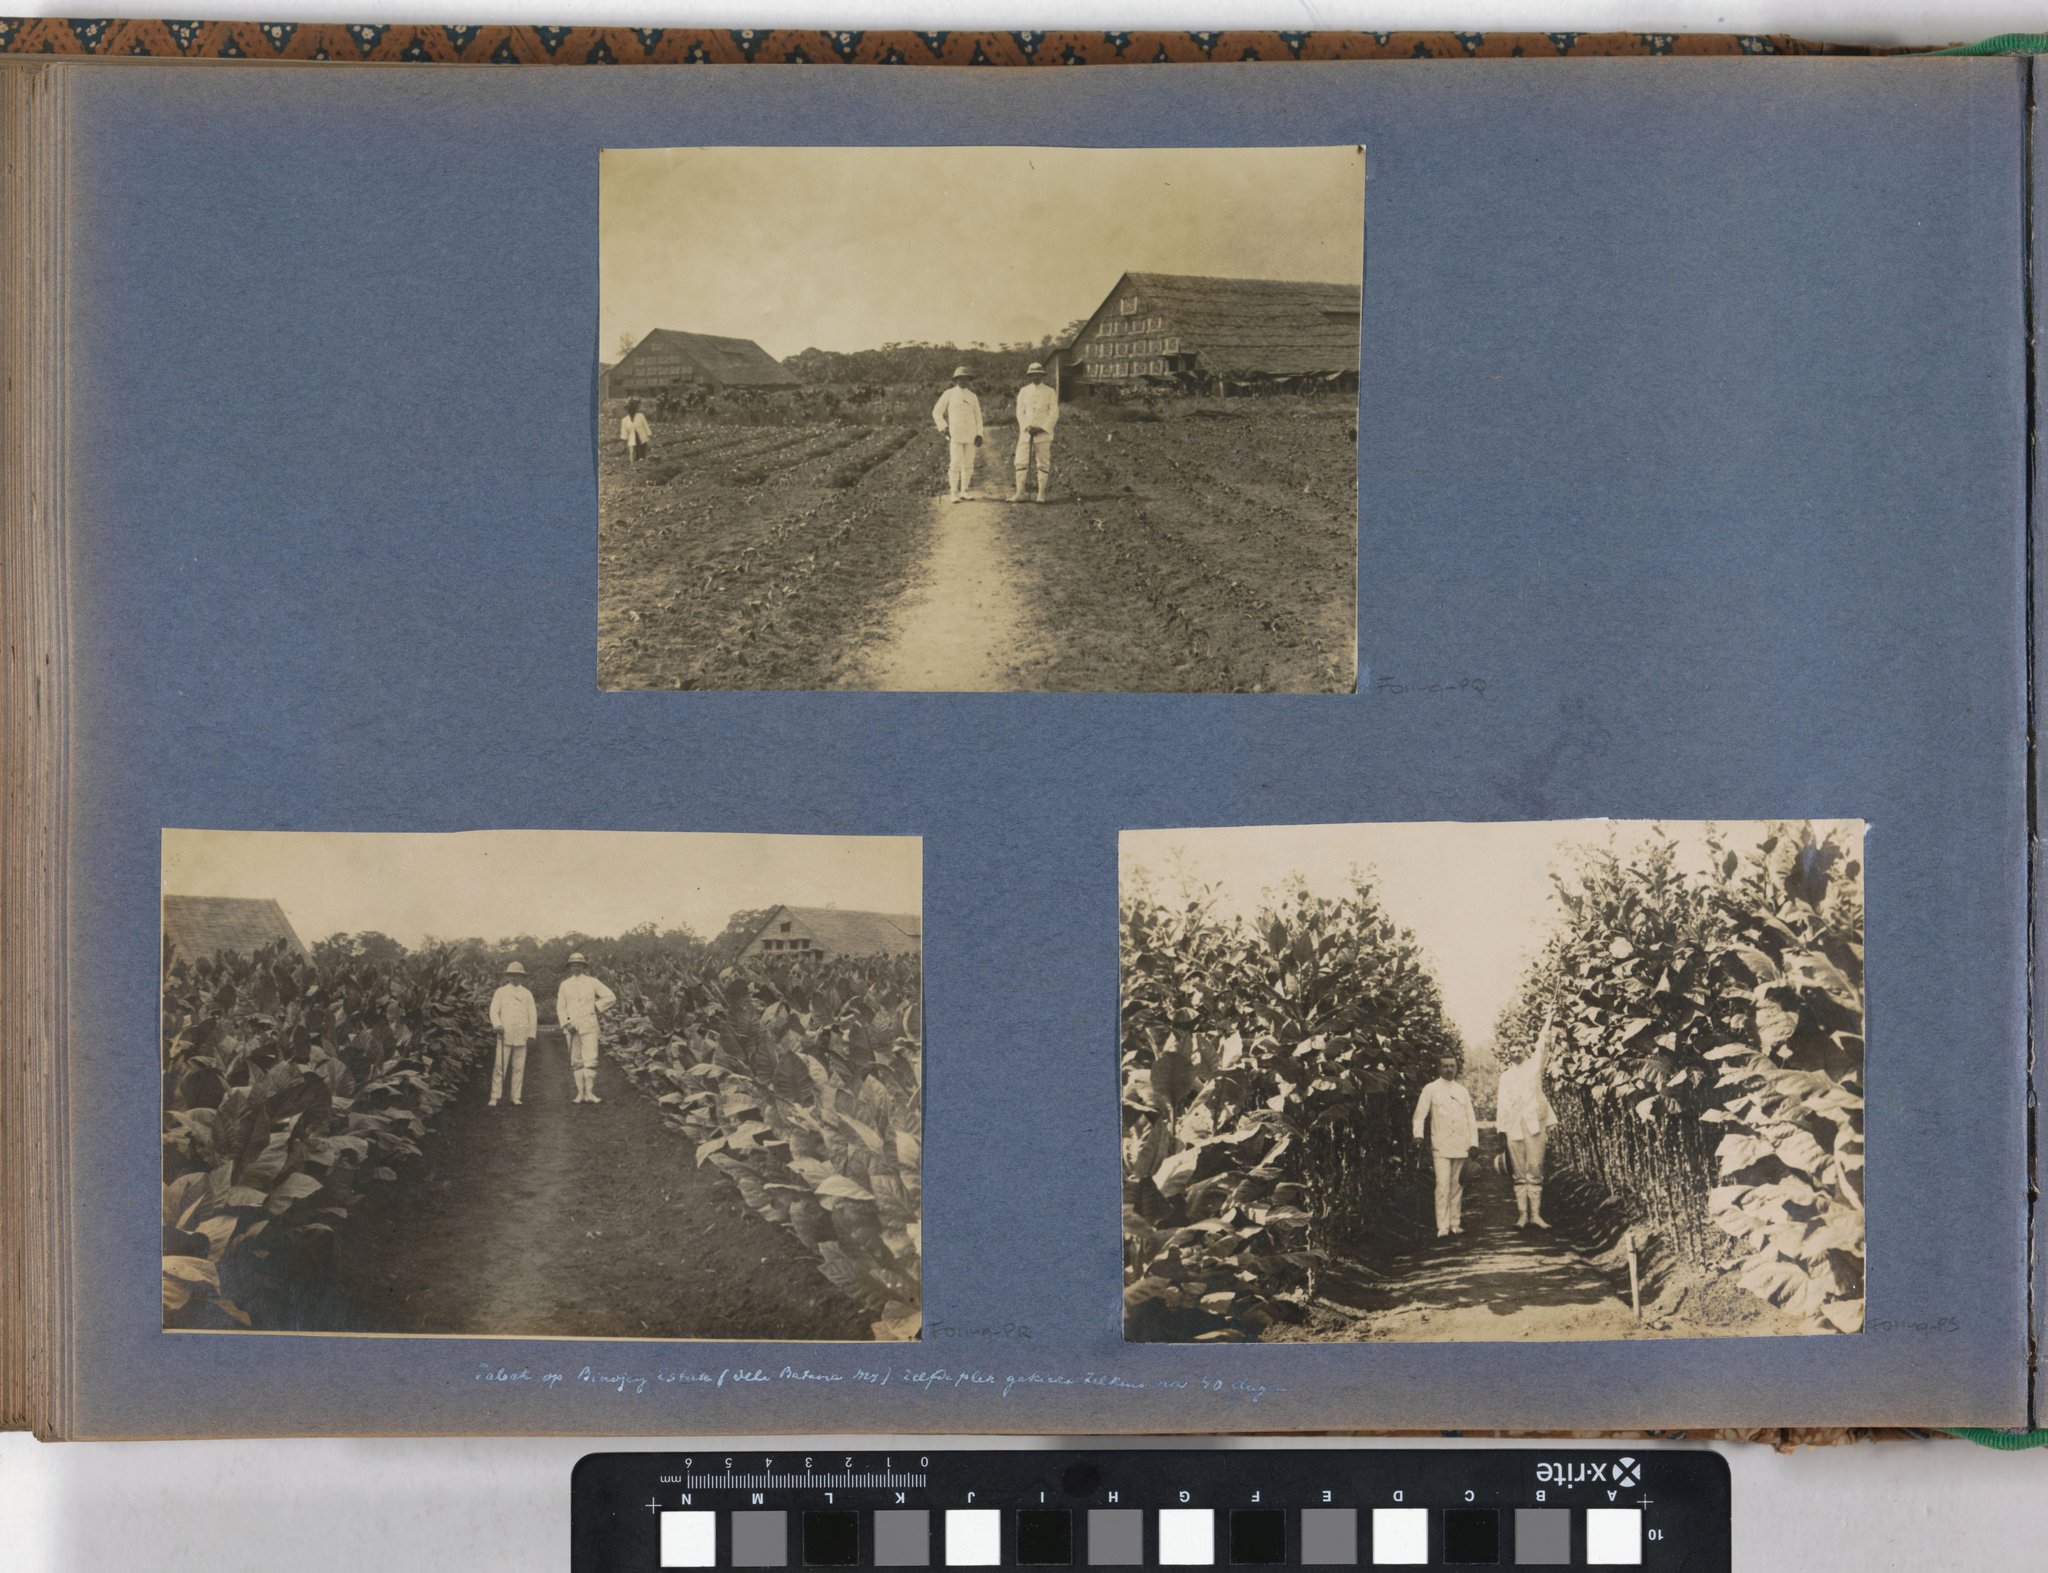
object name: album leaf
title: Tabaksveld op het Bindjey Estate van de Deli-Batavia Maatschappij op Sumatra (80 dagen na aanplant)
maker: Anonymous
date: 1900-1920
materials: paper, photographic support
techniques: gelatin silver print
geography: sumatra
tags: plantation, field filled with a crop, tobacco, sumatra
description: Foto 3 uit serie van 3. Onderdeel van reisalbum met foto's van bedrijvigheid en bezienswaardigheden op Sumatra en Java en van de reis naar en van Nederlands-Indië.